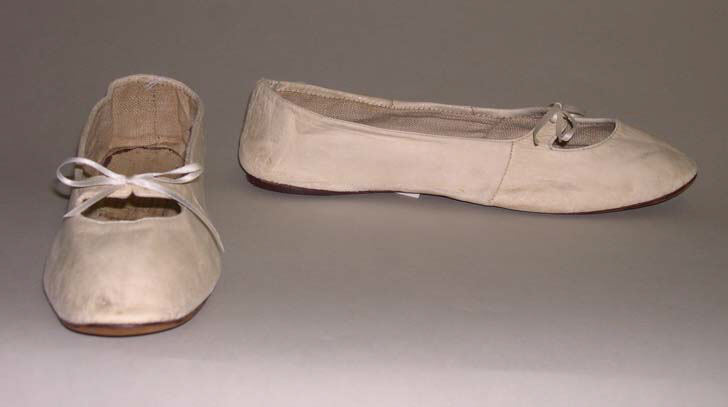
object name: slipper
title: Slippers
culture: american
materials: leather